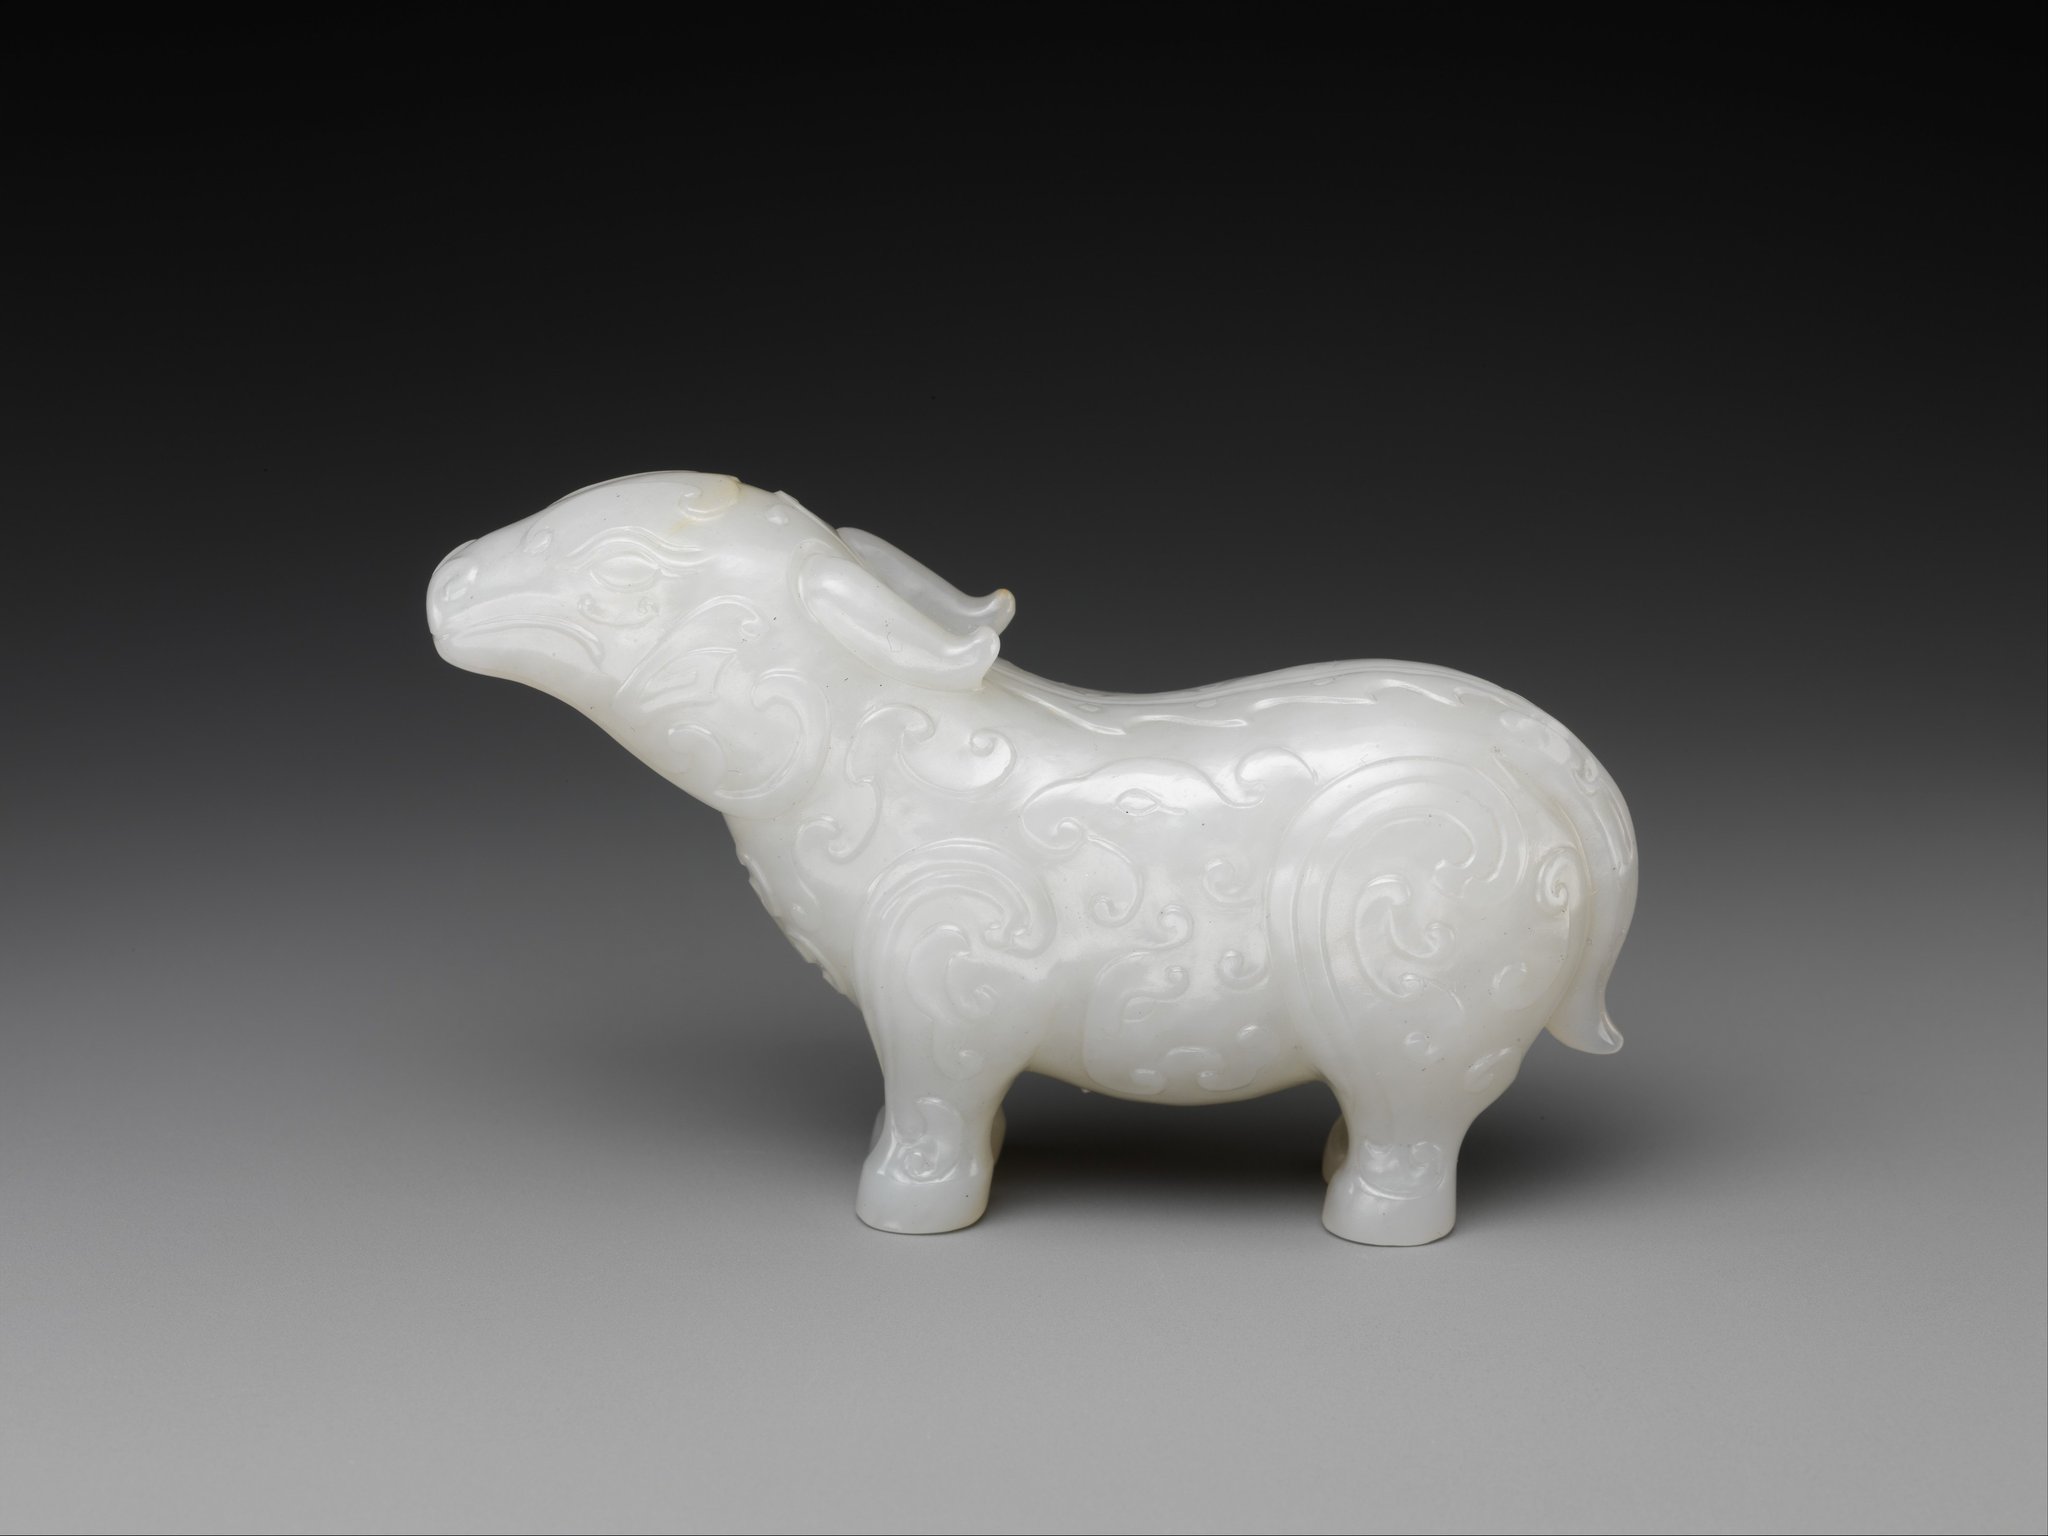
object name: figure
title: Fantastic animal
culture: chinese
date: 1701-1800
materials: jade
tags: animals